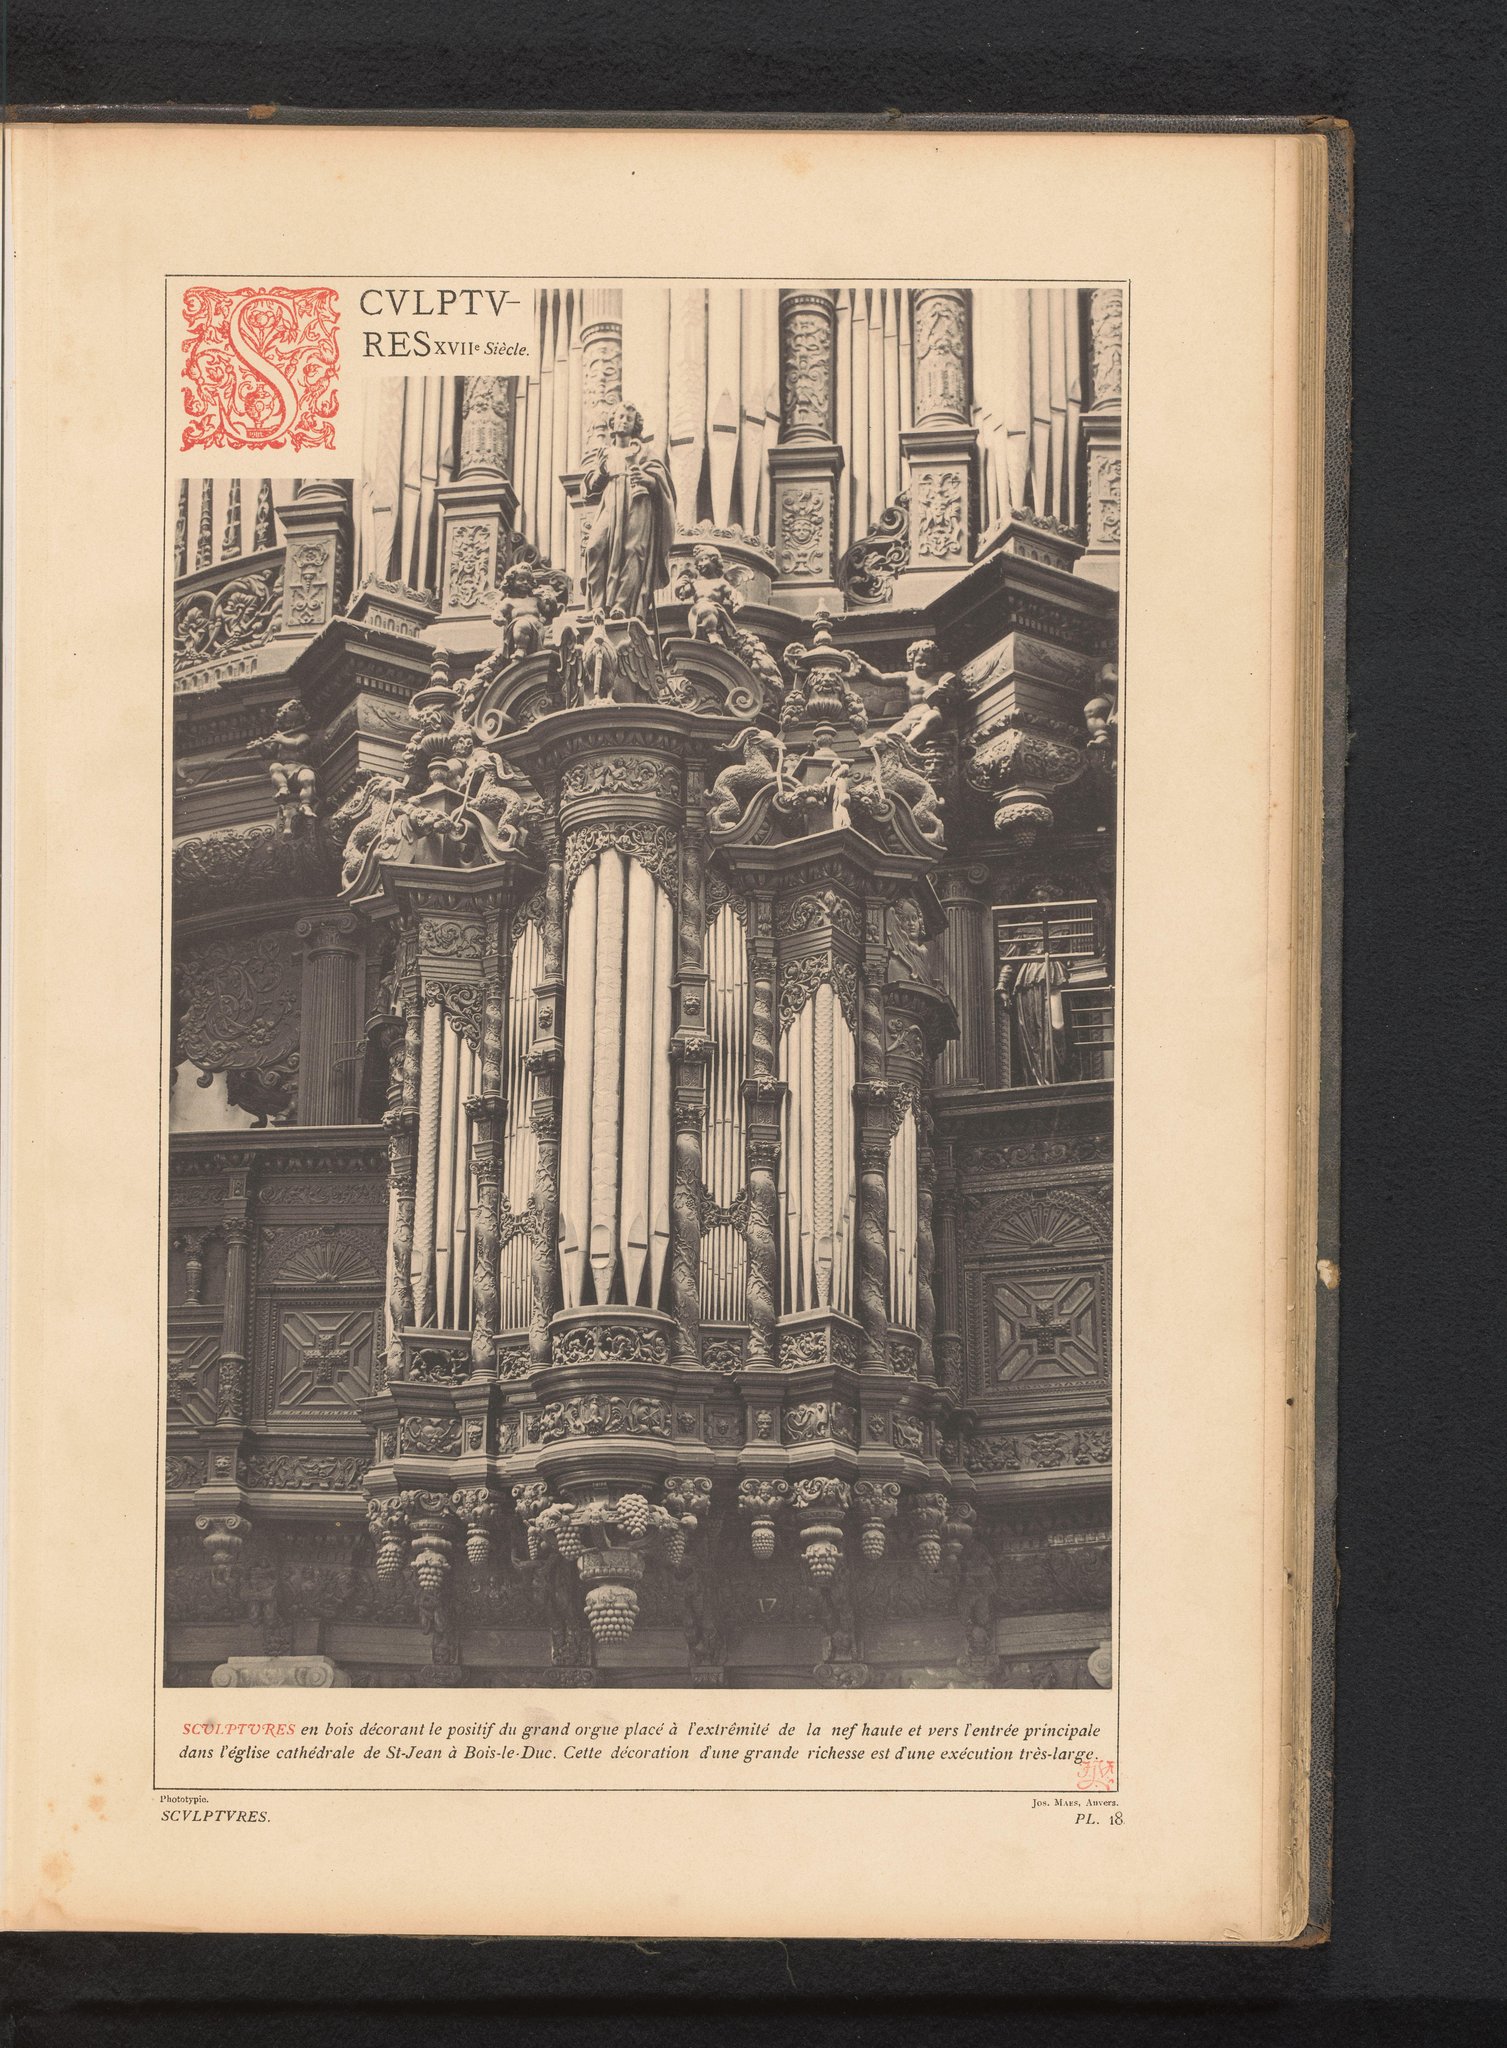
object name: page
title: Houten sculptuur op het orgel in de Sint-Janskathedraal te Den Bosch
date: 1881-1889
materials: paper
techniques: photograph, photolithography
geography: antwerp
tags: church organ, sculpture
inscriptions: monogram: ‘JJvY’, inscription: ‘SCULPTURES. PL. 18.’, inscription: ‘SCULPTURES en bois (...)’